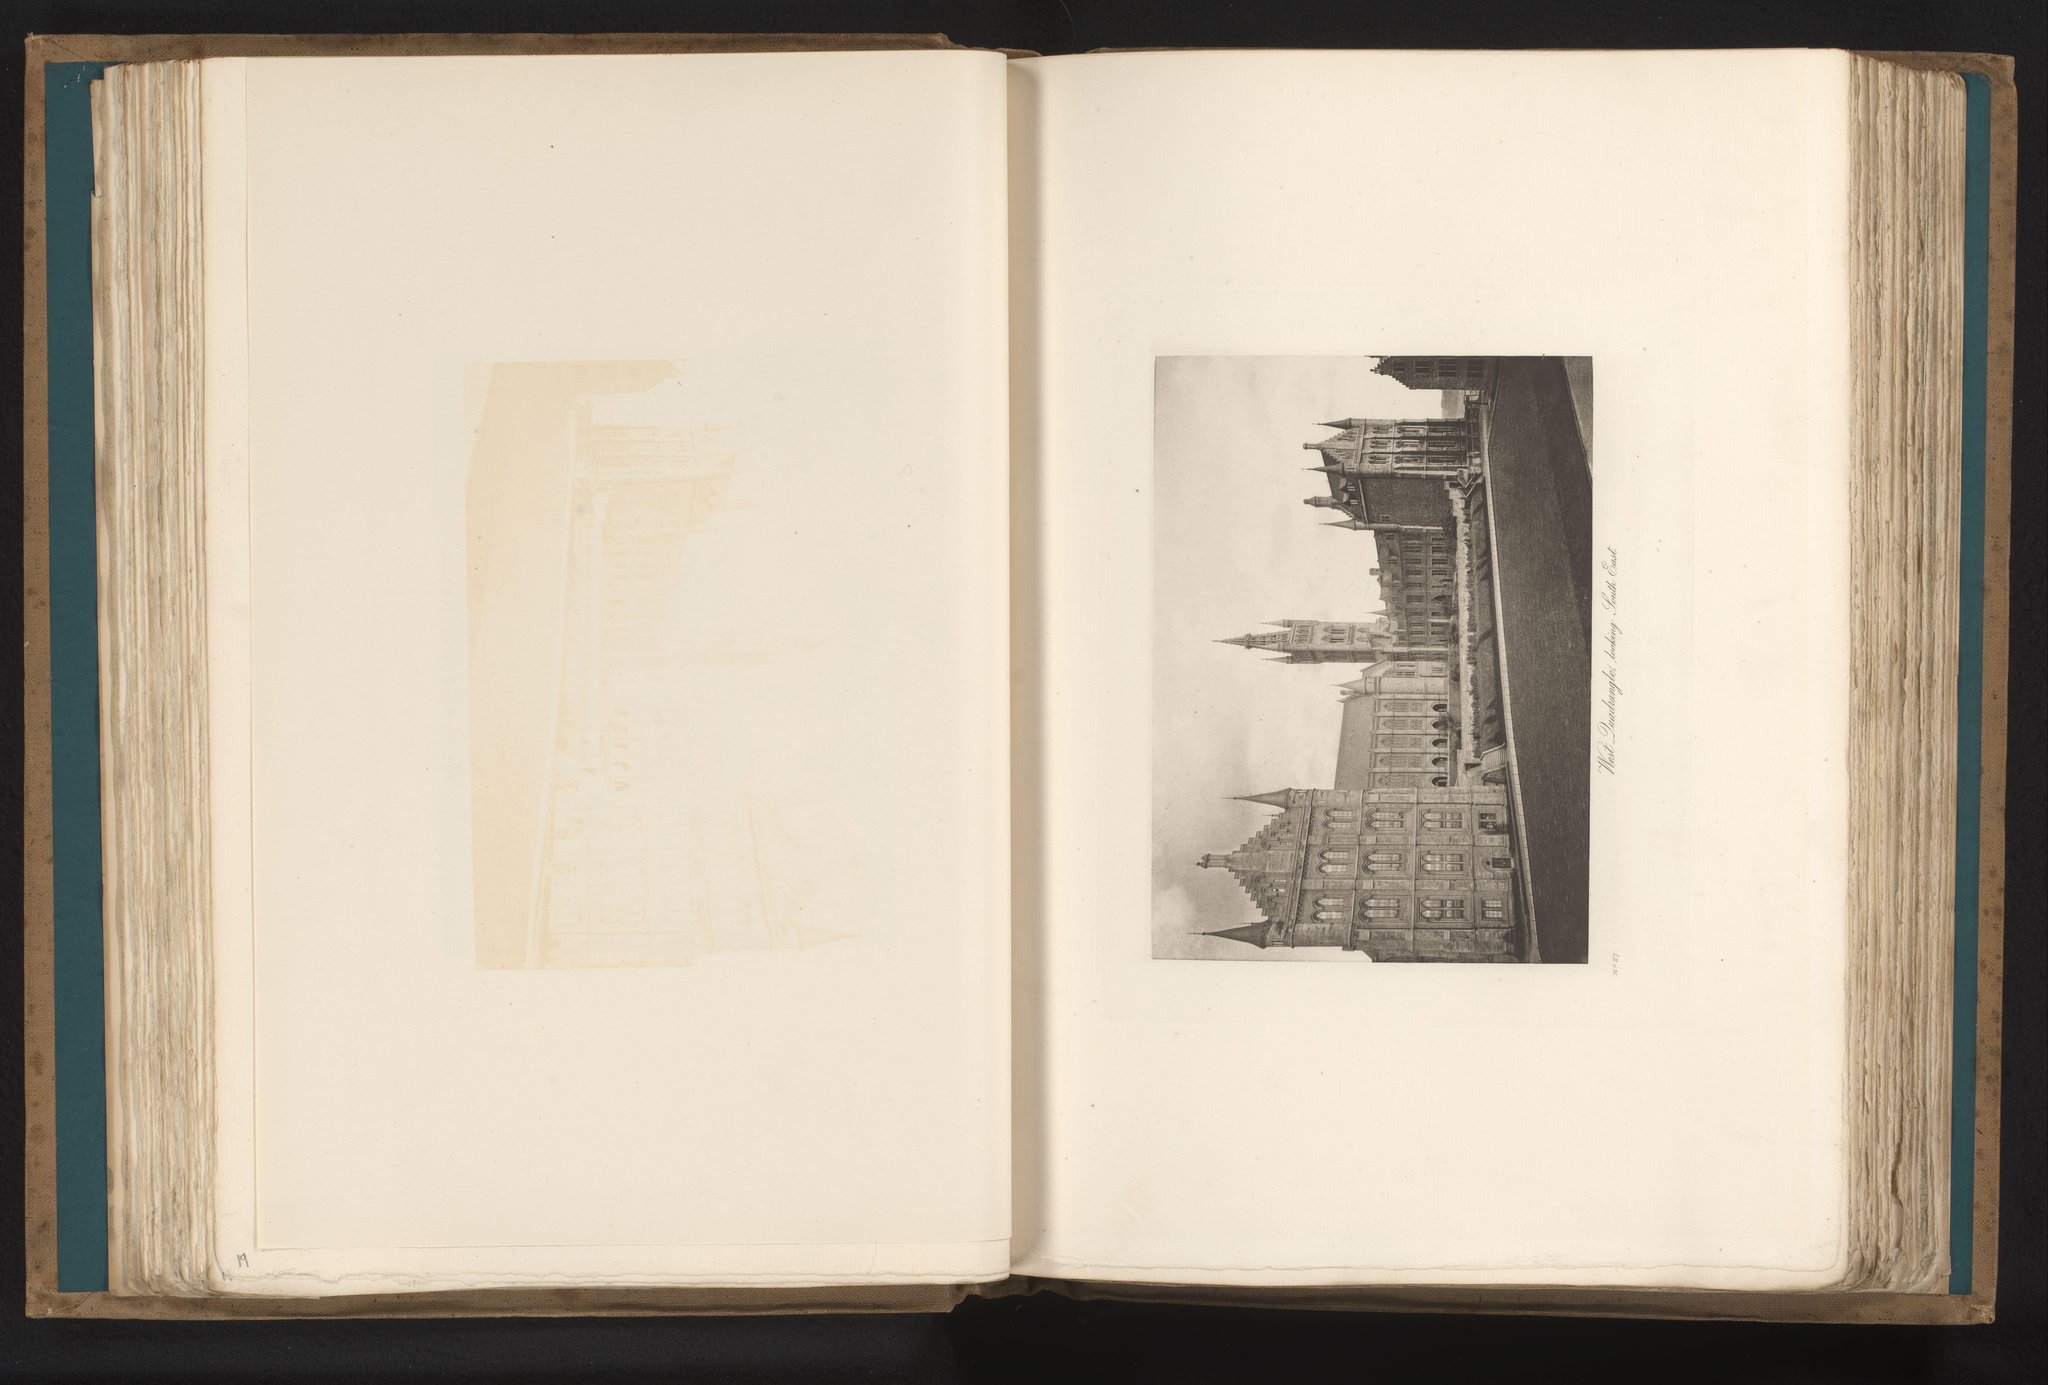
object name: photomechanical print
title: West Quadrangle looking South East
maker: Anonymous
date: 1886-1891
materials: paper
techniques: photoaquatint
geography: glasgow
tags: university (+ building ~ education, tuition), courtyard, glasgow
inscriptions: inscription: ‘No.27’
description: Prent op twintigste ongenummerde pagina na pagina xxxiii.